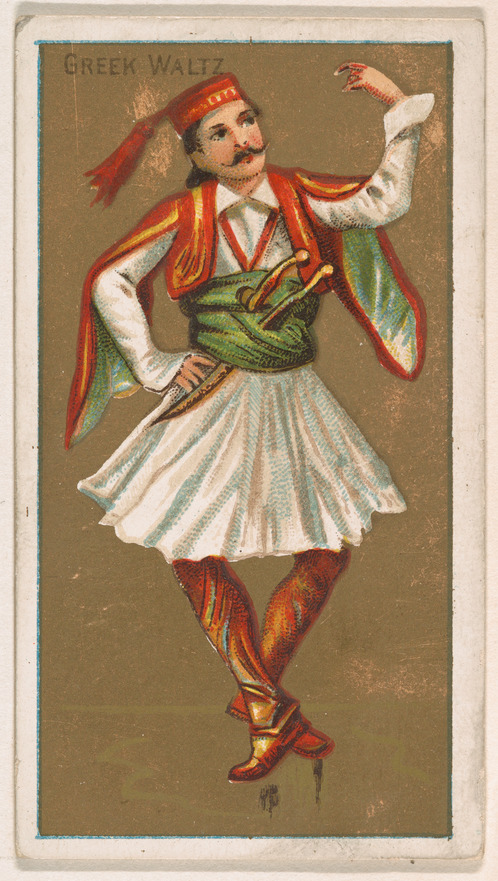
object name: print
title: Greek Waltz, from National Dances (N225, Type 1) issued by Kinney Bros.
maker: kinney brothers tobacco company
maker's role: publisher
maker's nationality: american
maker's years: 1869-2011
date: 1889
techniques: color lithograph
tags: men,dancing,dancers